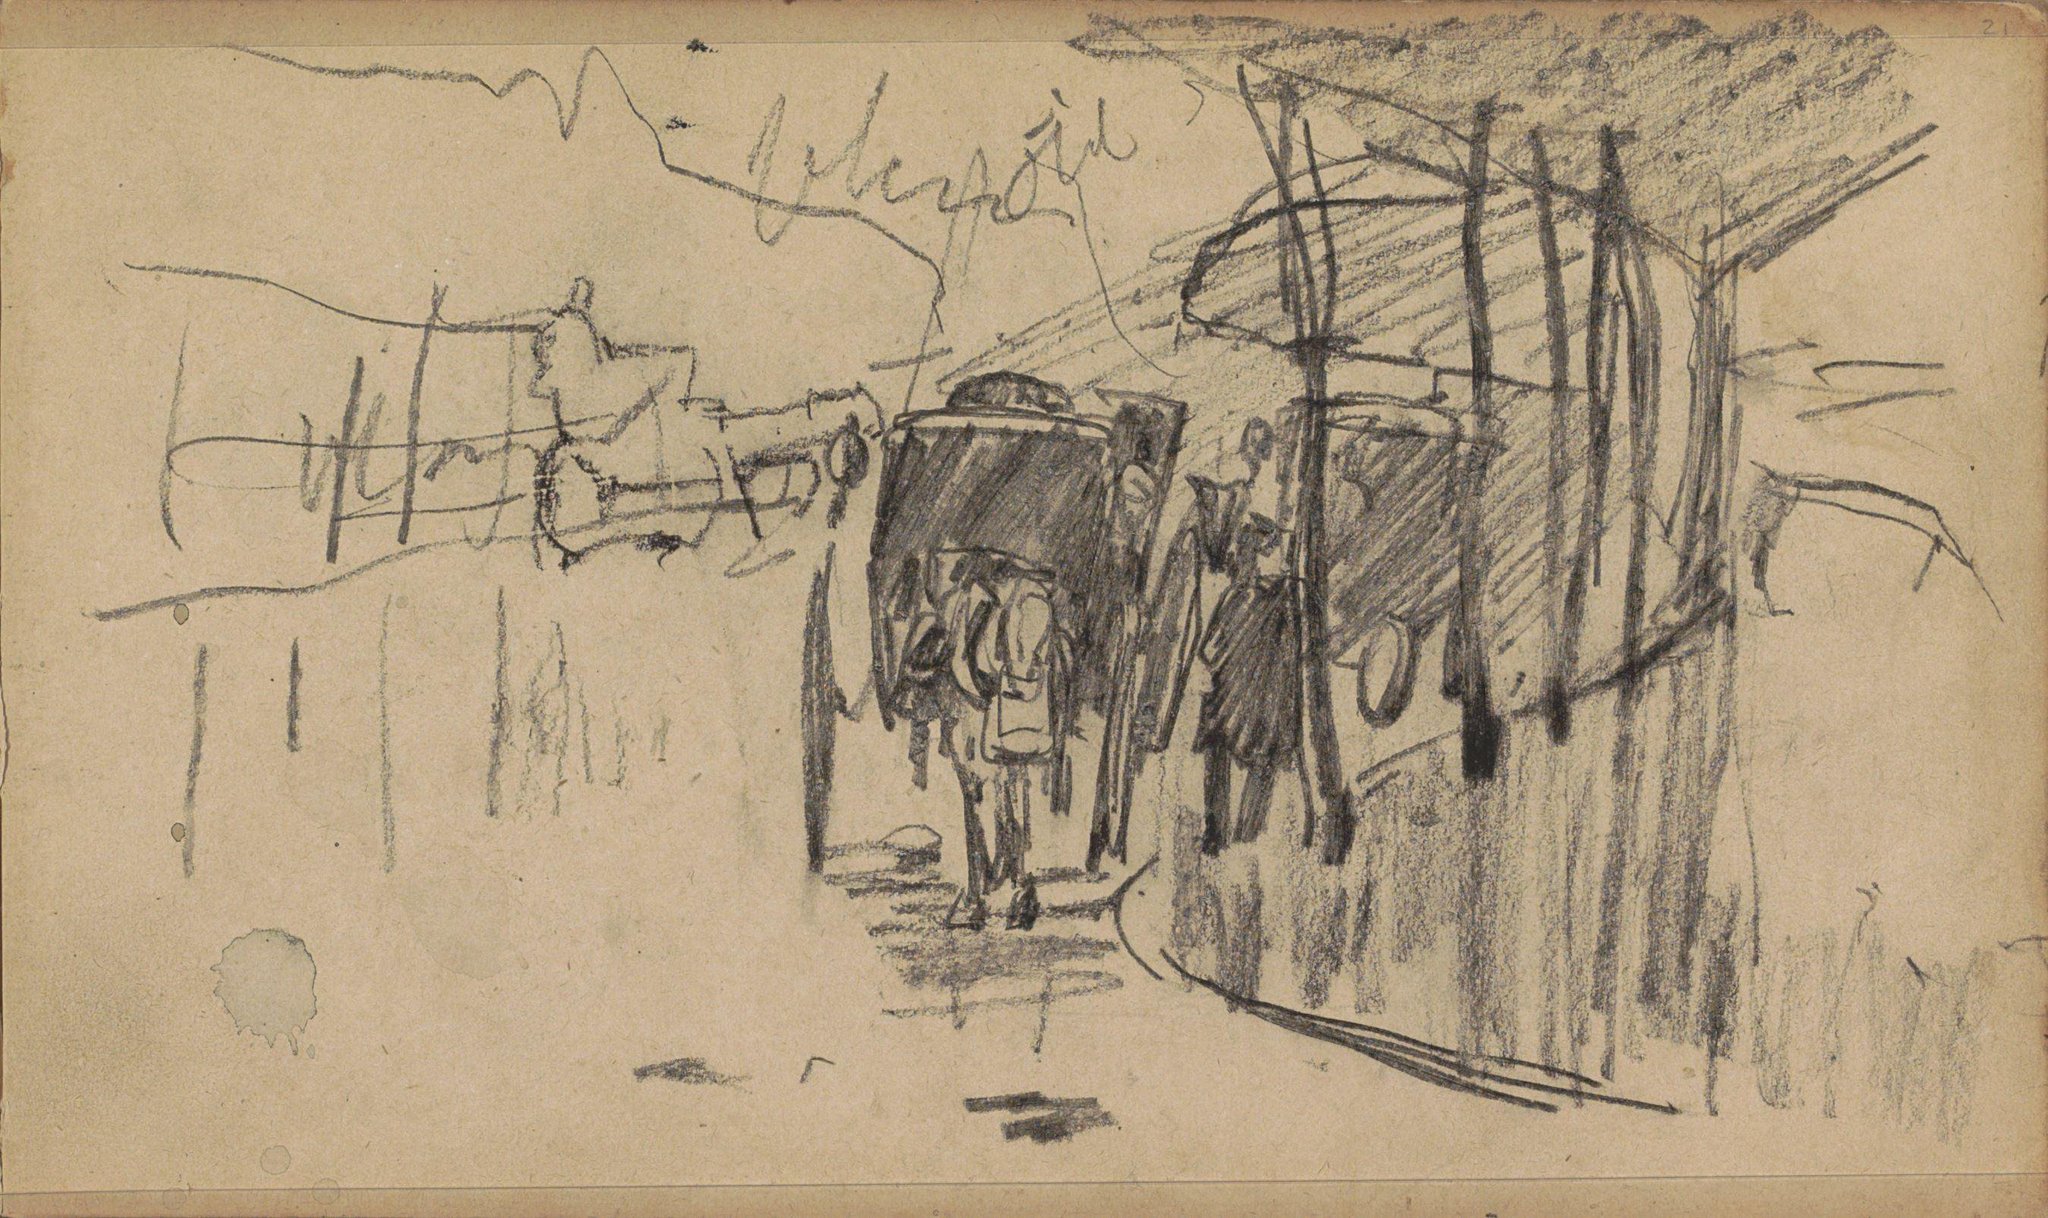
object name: sketchbook leaf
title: Wachtende rijtuigen in Londen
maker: willem witsen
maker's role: draughtsman, painter, print maker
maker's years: 1860-1923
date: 1888-1891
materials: chalk, paper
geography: london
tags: four-wheeled, animal-drawn vehicle, e.g.: cab, carriage, coach, road, path, london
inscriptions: kleurnotitie, handgeschreven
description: Voorstudie voor de ets 'Wachtende rijtuigen, Londen', ca. 1890-1908.